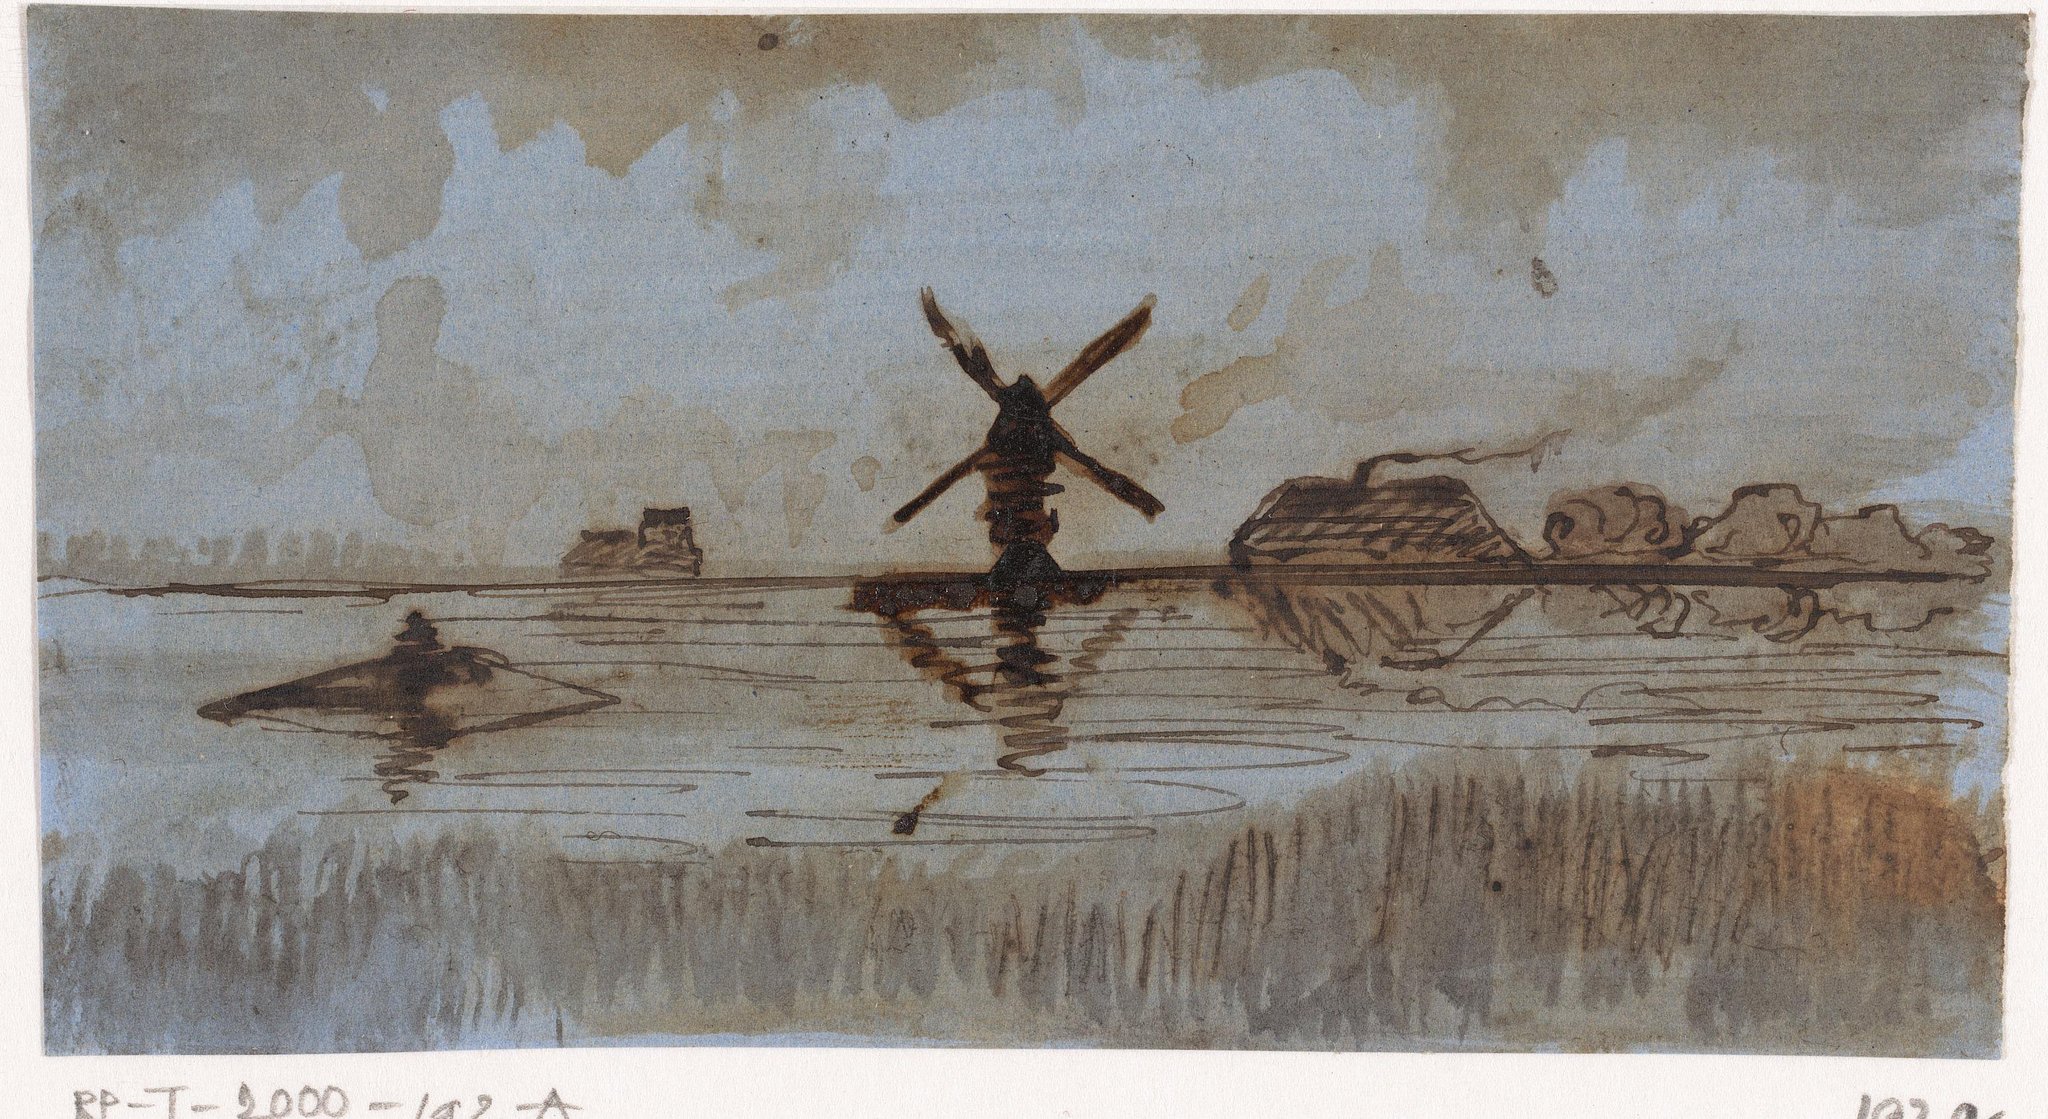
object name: drawing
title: Rivierlandschap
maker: johannes tavenraat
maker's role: draughtsman, painter, print maker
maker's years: 1809-1881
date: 1840-1880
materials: ink, paper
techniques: brush, pen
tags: windmill in landscape, river (+ landscape with figures, staffage)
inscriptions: collector's mark: Lugt 2228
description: Rivierlandschap met roeiboot en molen. Getekend op de achterzijde van een drukwerk met reclame voor 'Winter-Artikelen'.